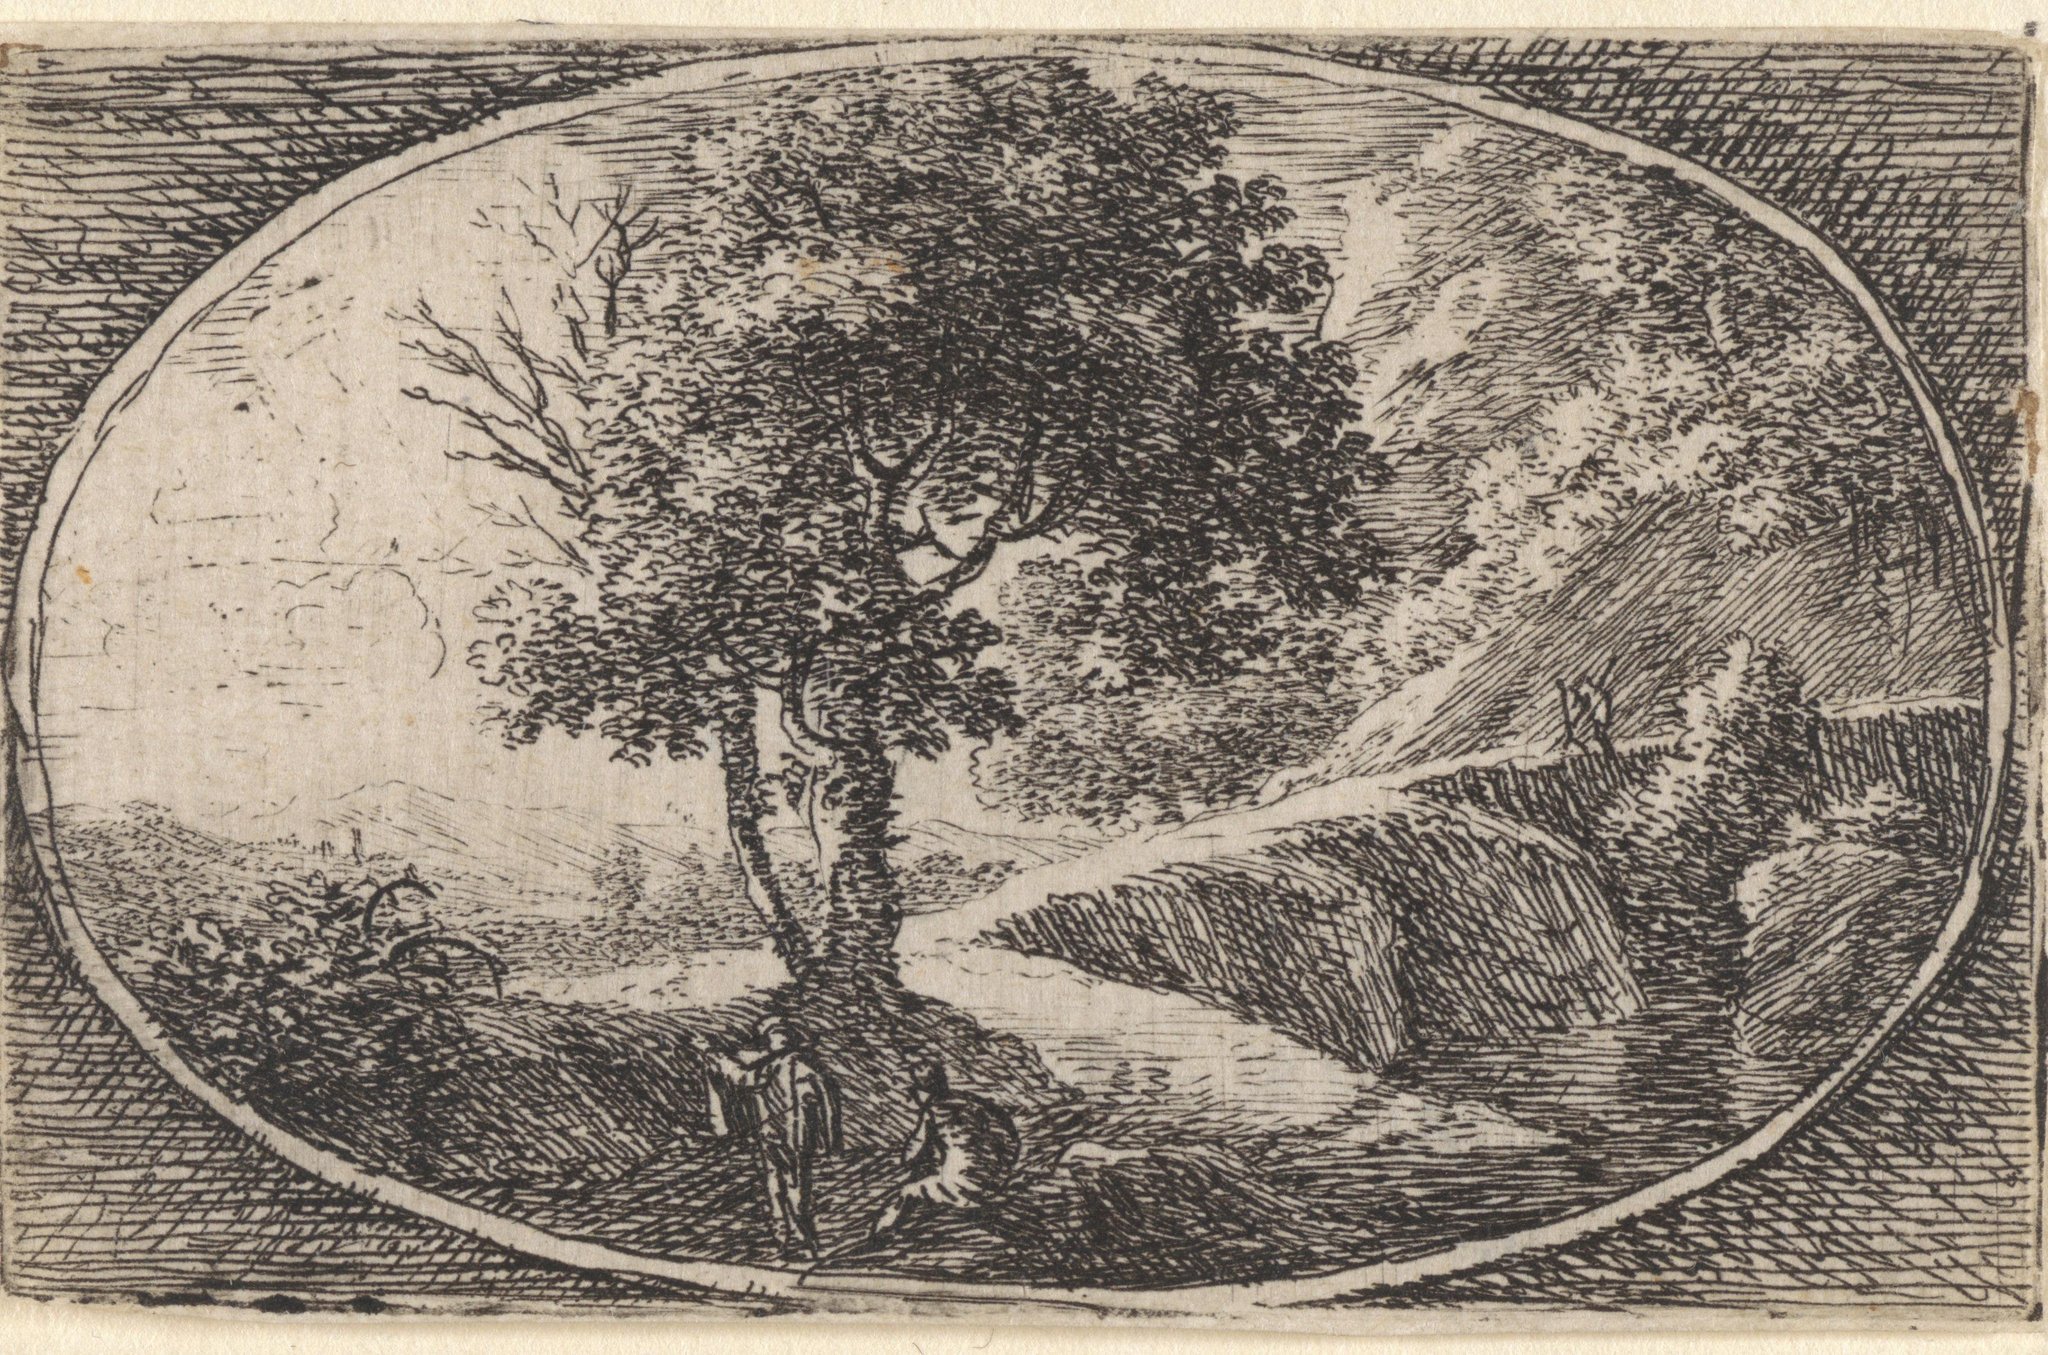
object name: print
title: Variae campestru fantasiae a Hermano van Suanevelt invent et in lucem edita (...)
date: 1650-1655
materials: paper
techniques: etching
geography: paris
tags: landscapes, sitting on the ground, 'en route', traveller under way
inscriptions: collector's mark: Lugt 2228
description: In een ovale omlijsting is een slingerend pad met enkele wandelaars te zien. Vooraan zit een figuur op de grond.